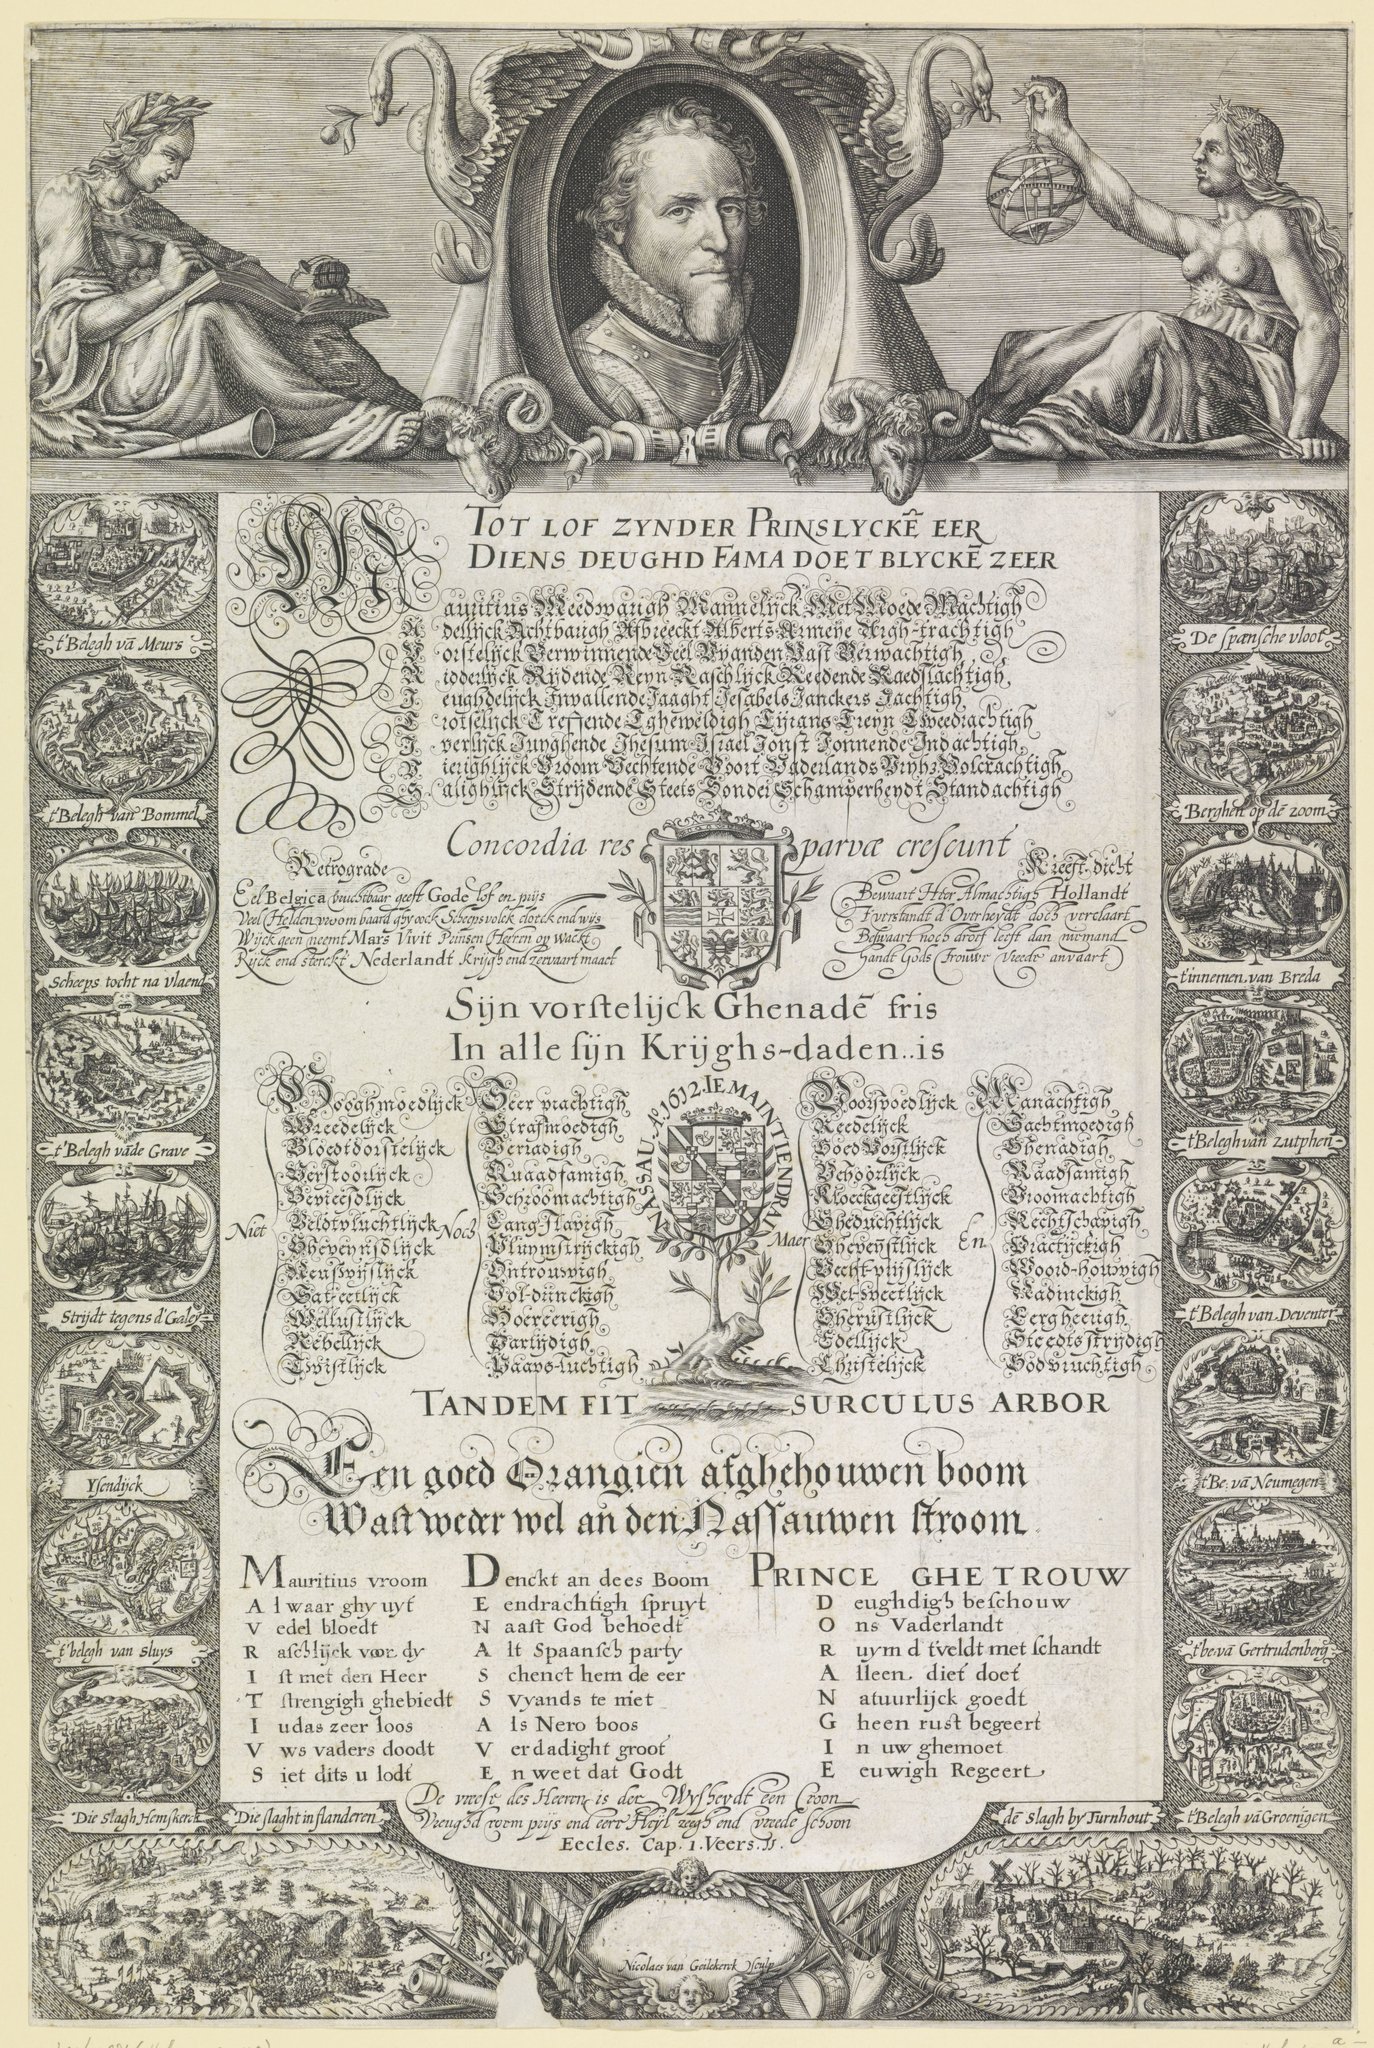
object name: print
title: Portret van Maurits, prins van Oranje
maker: nicolaes van geelkercken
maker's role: print maker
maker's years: 1585-1656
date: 1612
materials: paper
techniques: engraving, etching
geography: leiden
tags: the hague, maurice (prince of orange)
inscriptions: collector's mark: Lugt 2228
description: Portret van Maurits in een ovaal als hoofd van een lijst met veroveringen en veldslagen. In het midden een aantal kolommen met Nederlandse tekst, zijn wapen, de Oranjeboom met zijn lijfspreuk en zijn geslachtsspreuk. Rondom 18 medaillons met elk op een banderol de naam van de verovering of veldslag.